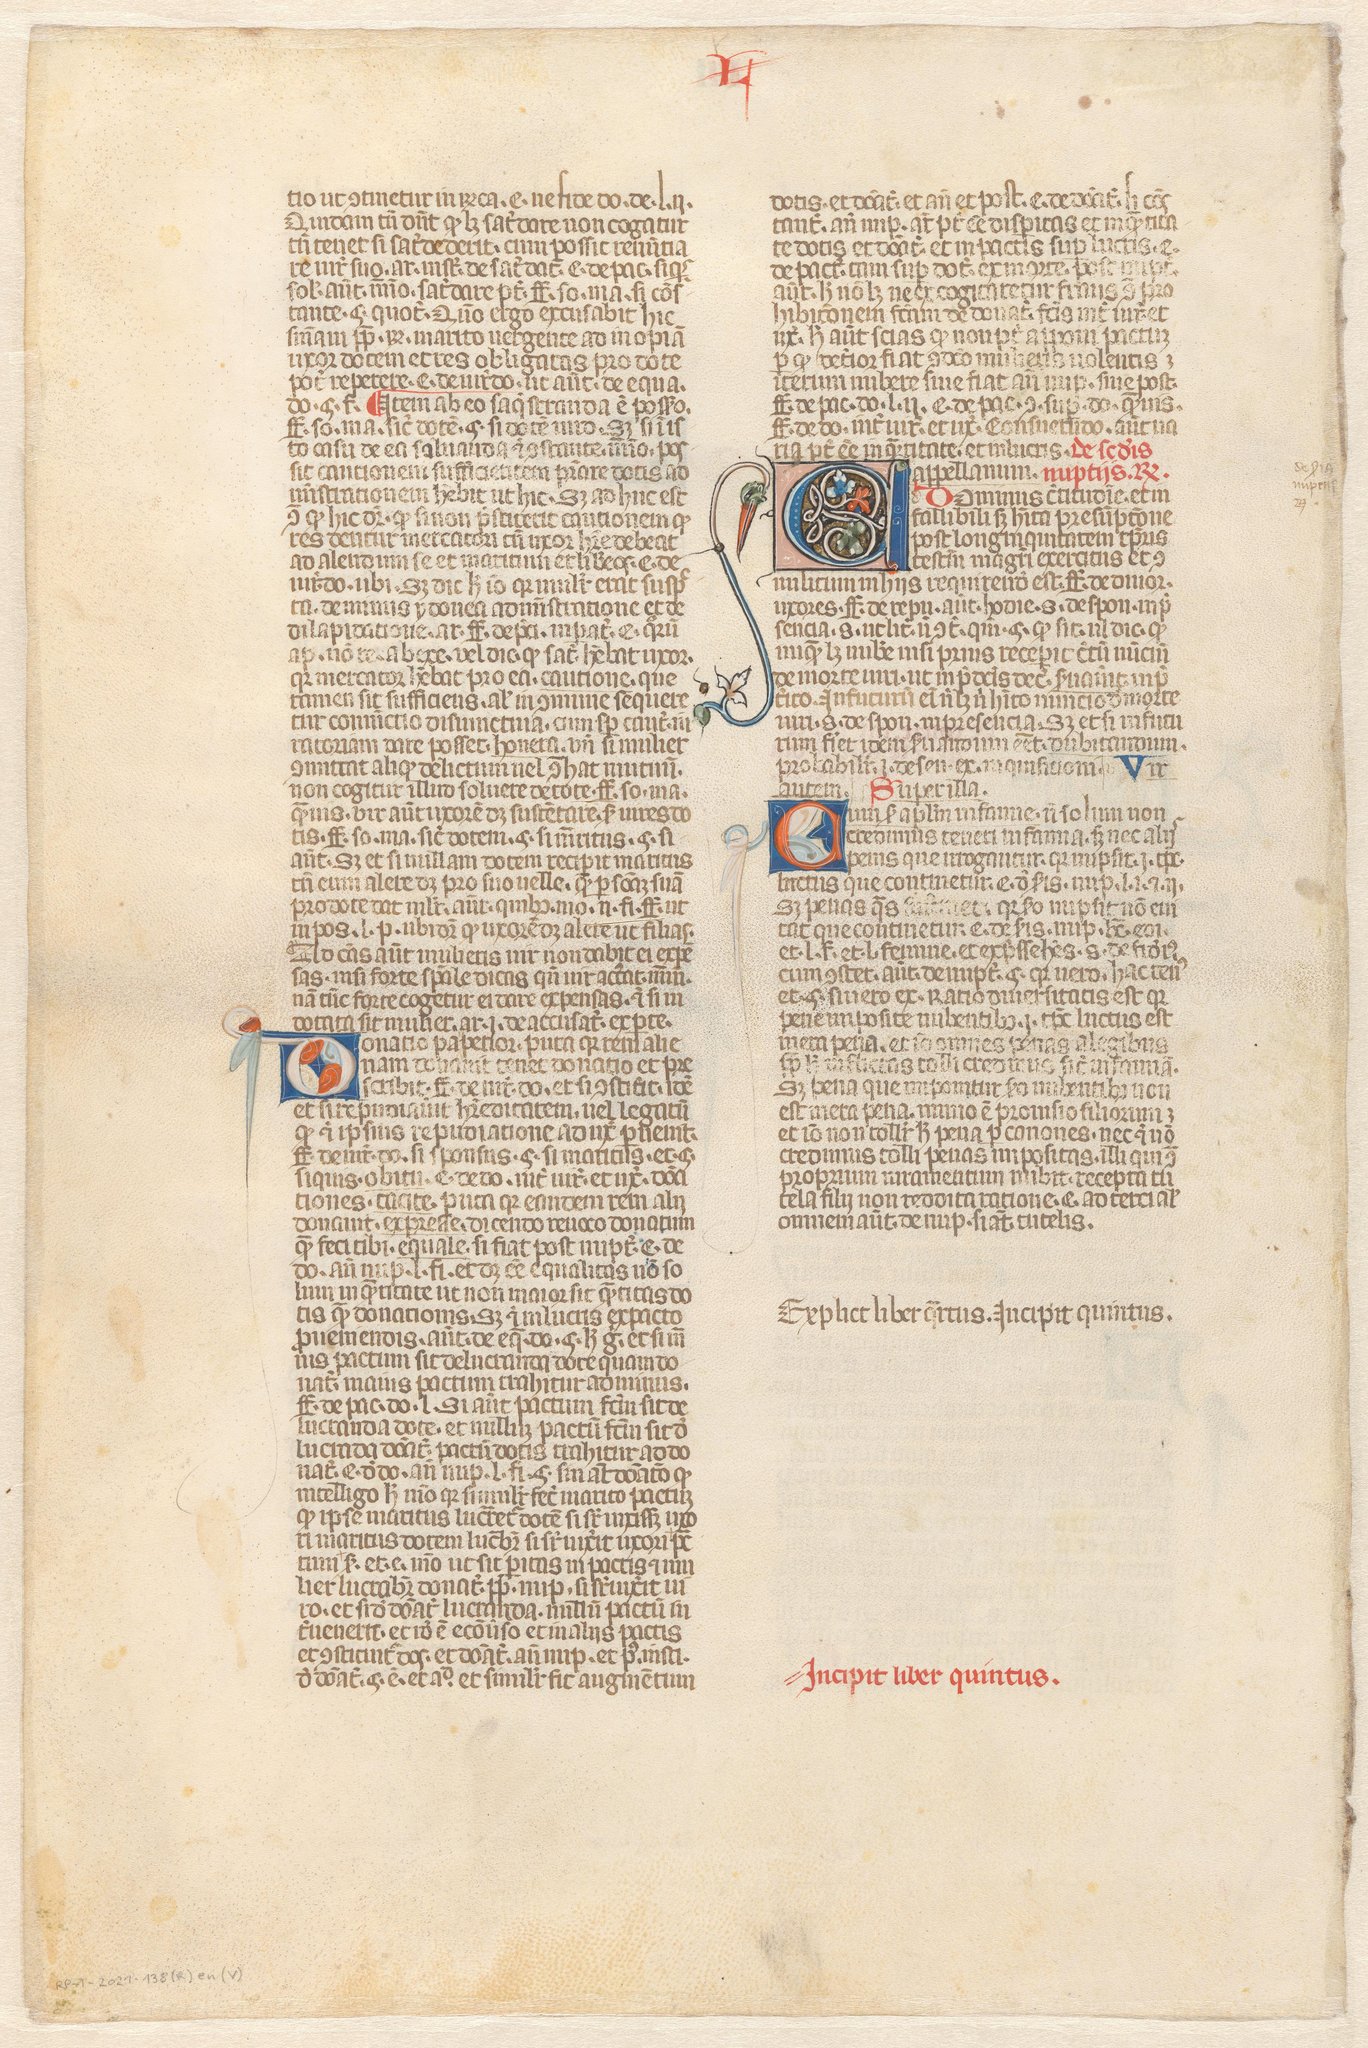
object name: drawing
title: Blad uit Gregorius IX, Decretales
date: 1300-1399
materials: paint, gold leaf, ink, parchment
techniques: brush, pen